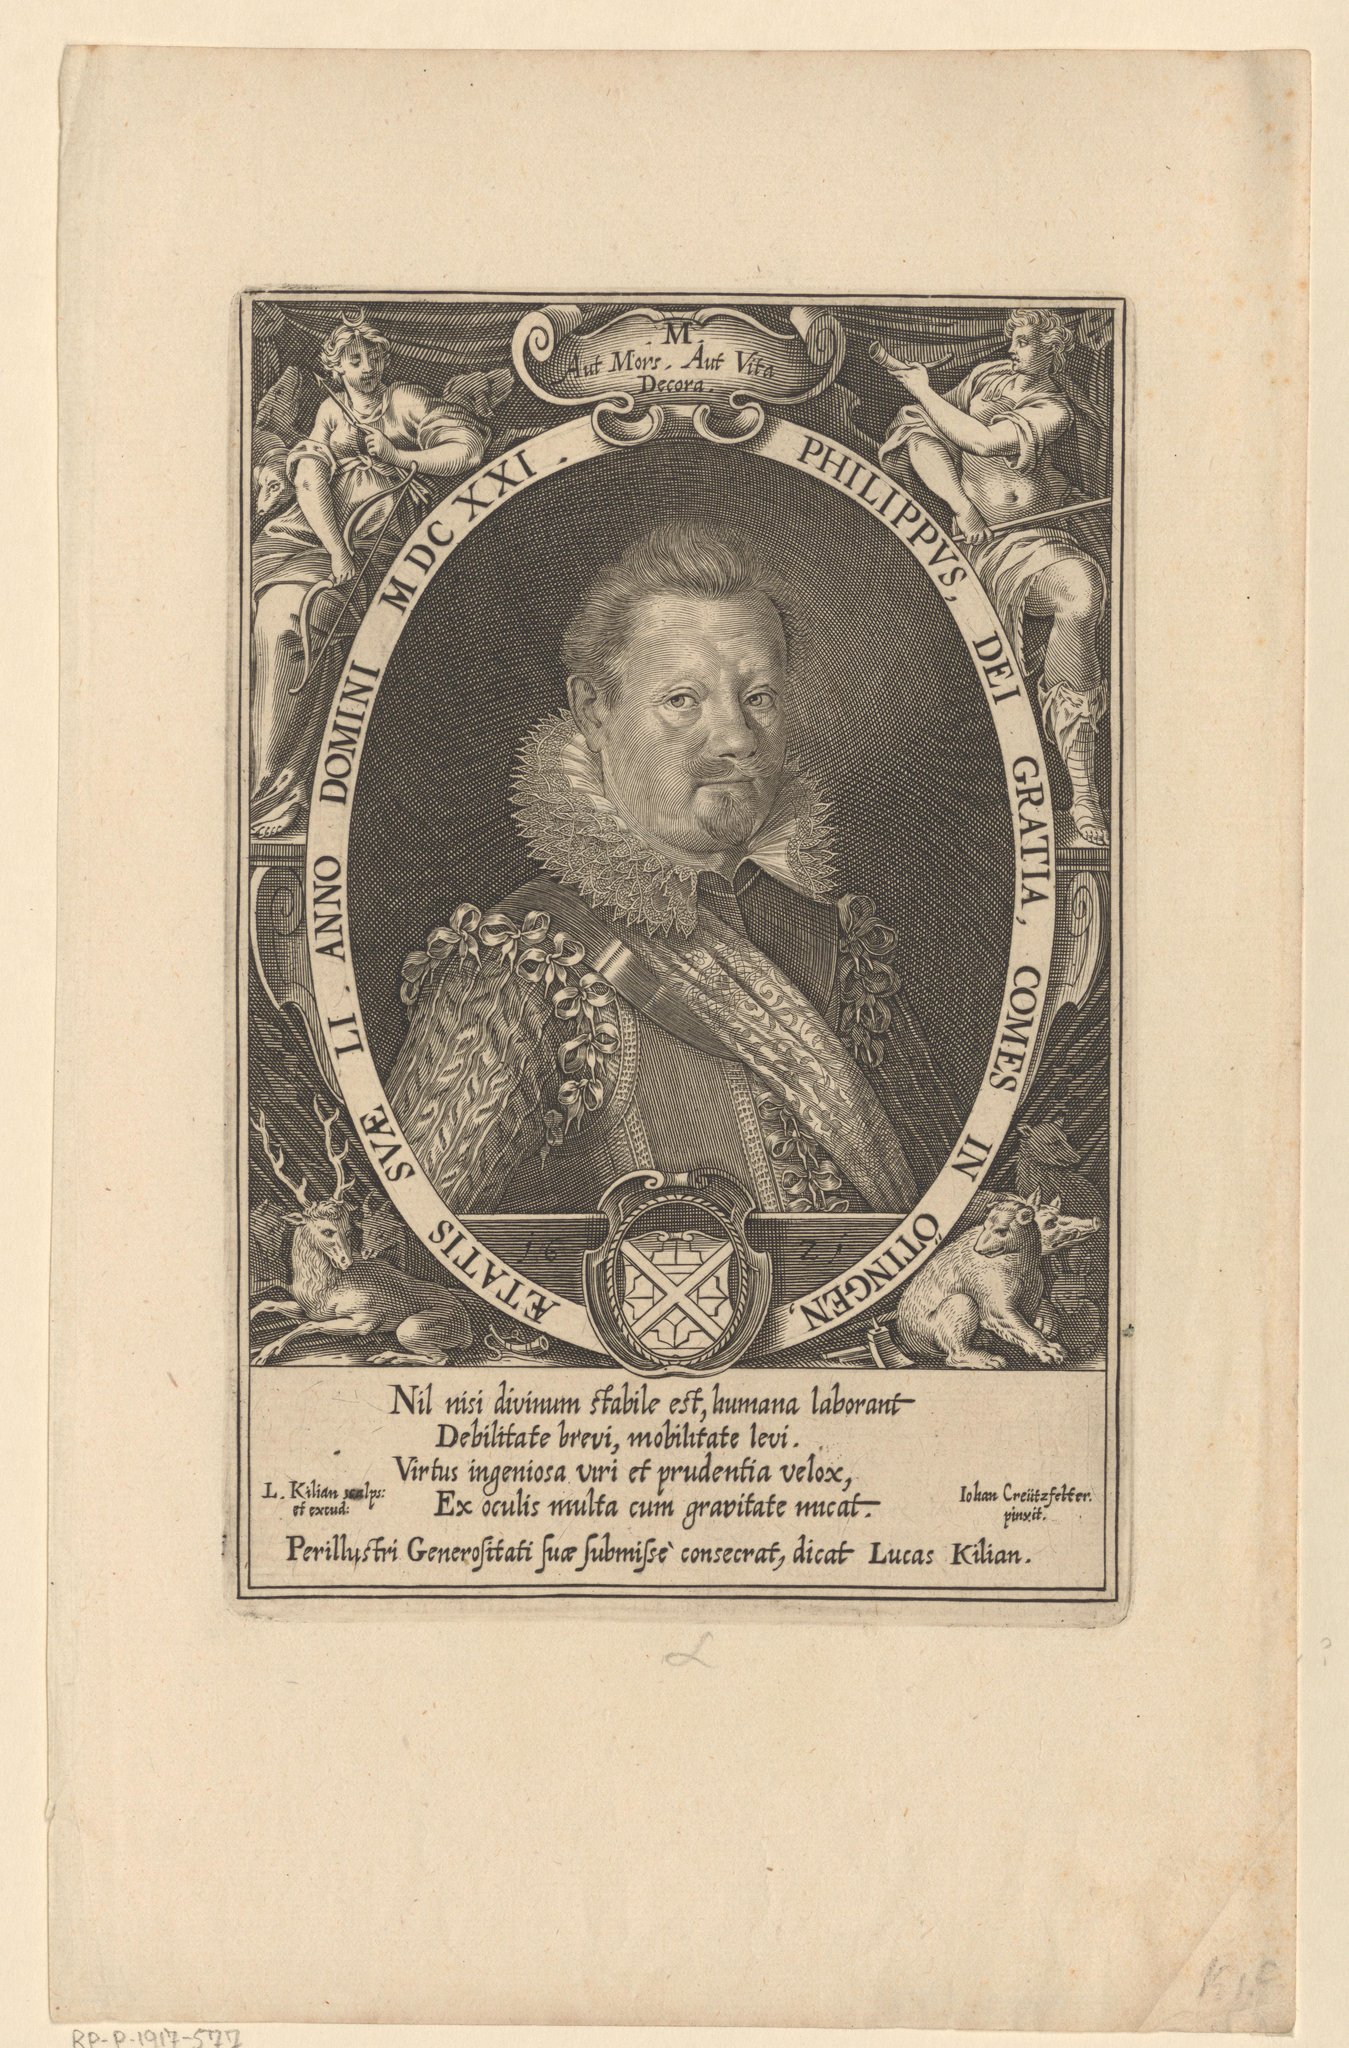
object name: print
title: Portret van graaf Philipp von Oettingen op 55-jarige leeftijd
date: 1621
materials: paper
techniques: engraving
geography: augsburg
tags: philipp von oettingen (graaf), historical persons, armorial bearing, heraldry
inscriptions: collector's mark: Lugt 2228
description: Onder het portret zijn wapenschild met daaronder het portret een vierregelig vers.